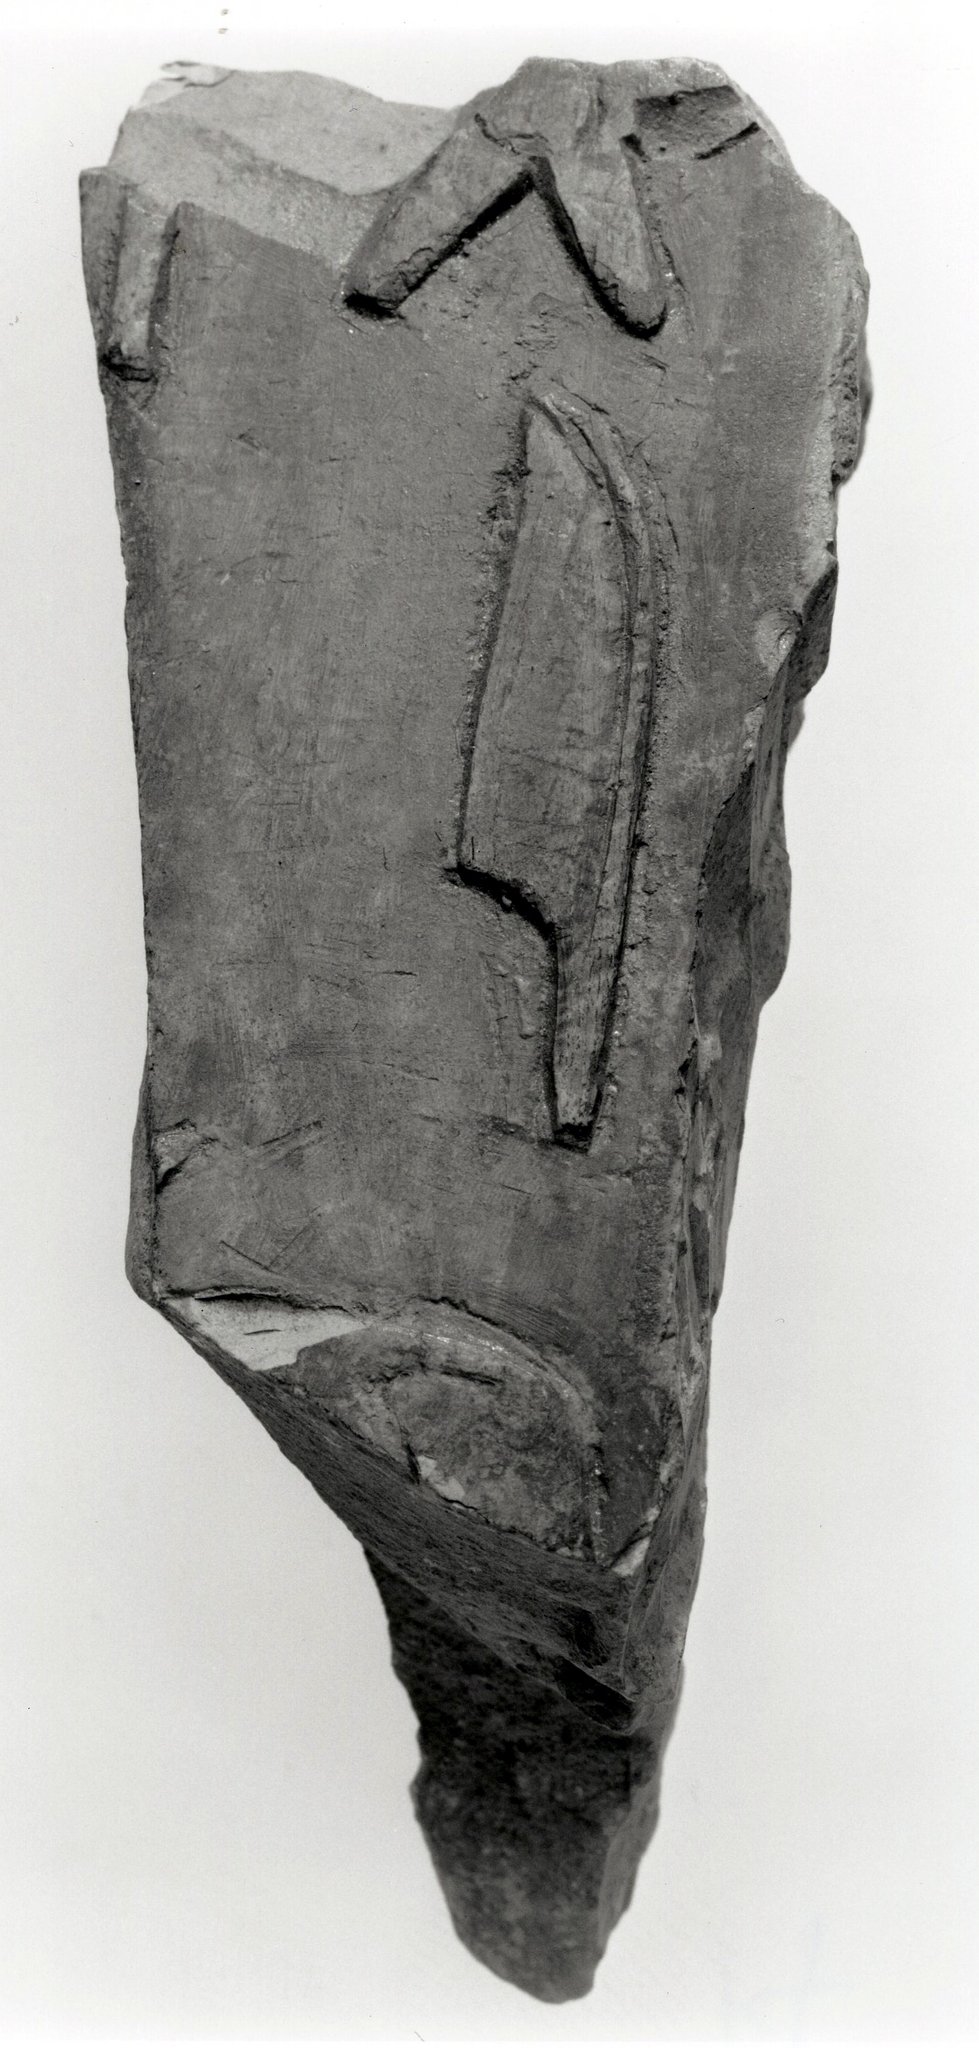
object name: relief, tomb of nespekashuty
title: Raised relief fragment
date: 664-610 BCE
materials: limestone, varnish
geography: egypt